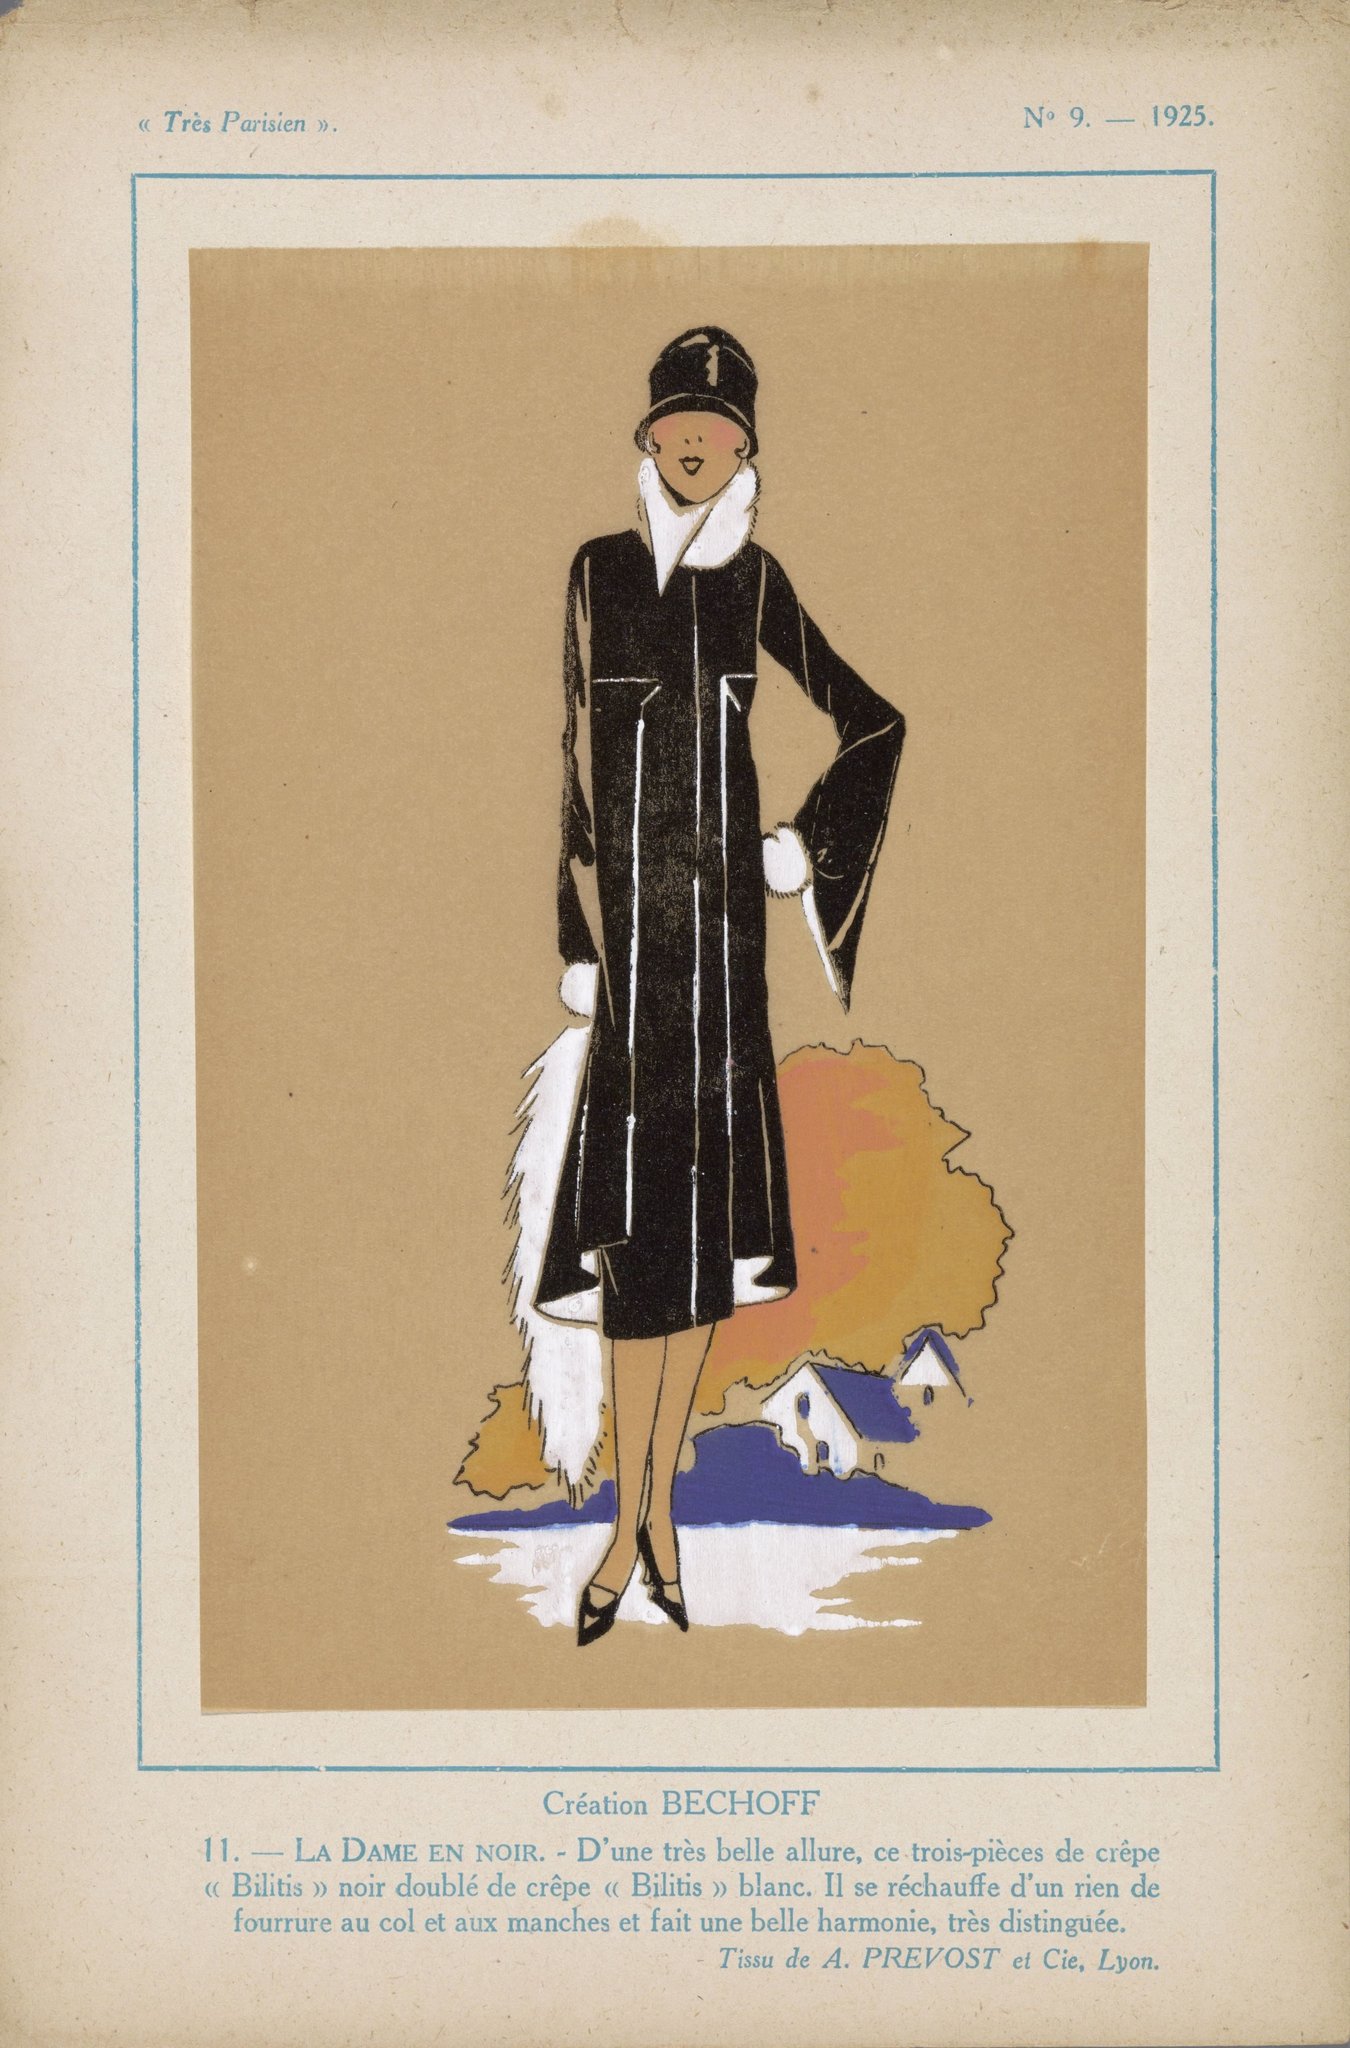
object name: fashion print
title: Très Parisien, 1925, No. 9, Pl. 11: Création BECHOFF - LA DAME EN NOIR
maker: g-p. joumard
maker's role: publisher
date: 1925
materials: paper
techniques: hand coloring, letterpress printing, lithography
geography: paris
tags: ensembles of pieces of clothing (three piece suit) (+ women's clothes), neck-gear: collar (+ women's clothes), fashion plates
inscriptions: caption: ‘11. - LA DAME EN NOIR. - D'une tres belle allure, ce trois-pièces de crêpe 'Bilitis' noir doublé de crêpe "Bilitis" blanc. Il se réchauffe d'un rien de fourrure au col et aux manches et fait une belle harmonie, très distinguée.’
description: Driedelig ensemble van zwarte en witte crêpe "Bilitis", afgezet met wit bont. Prent uit het modetijdschrift Très Parisien...La Mode, Le Chic, L'Élégance (1920-1936)